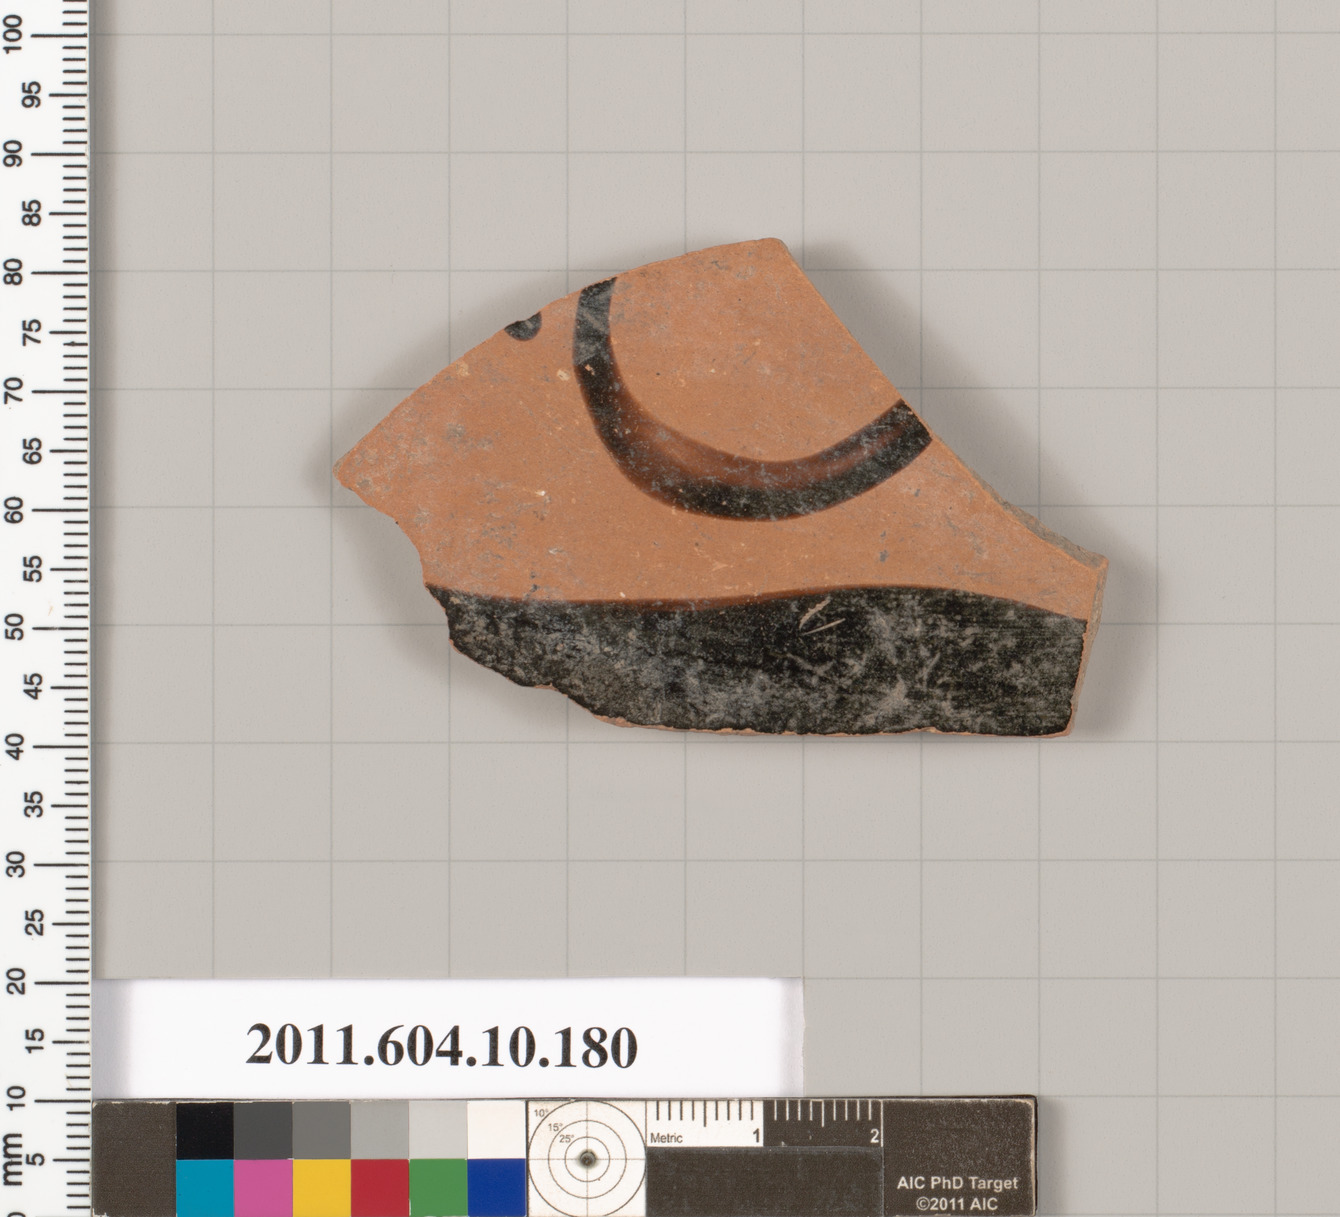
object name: undetermined closed shape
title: Terracotta fragment of a closed shape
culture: etruscan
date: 534-501 BCE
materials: terracotta